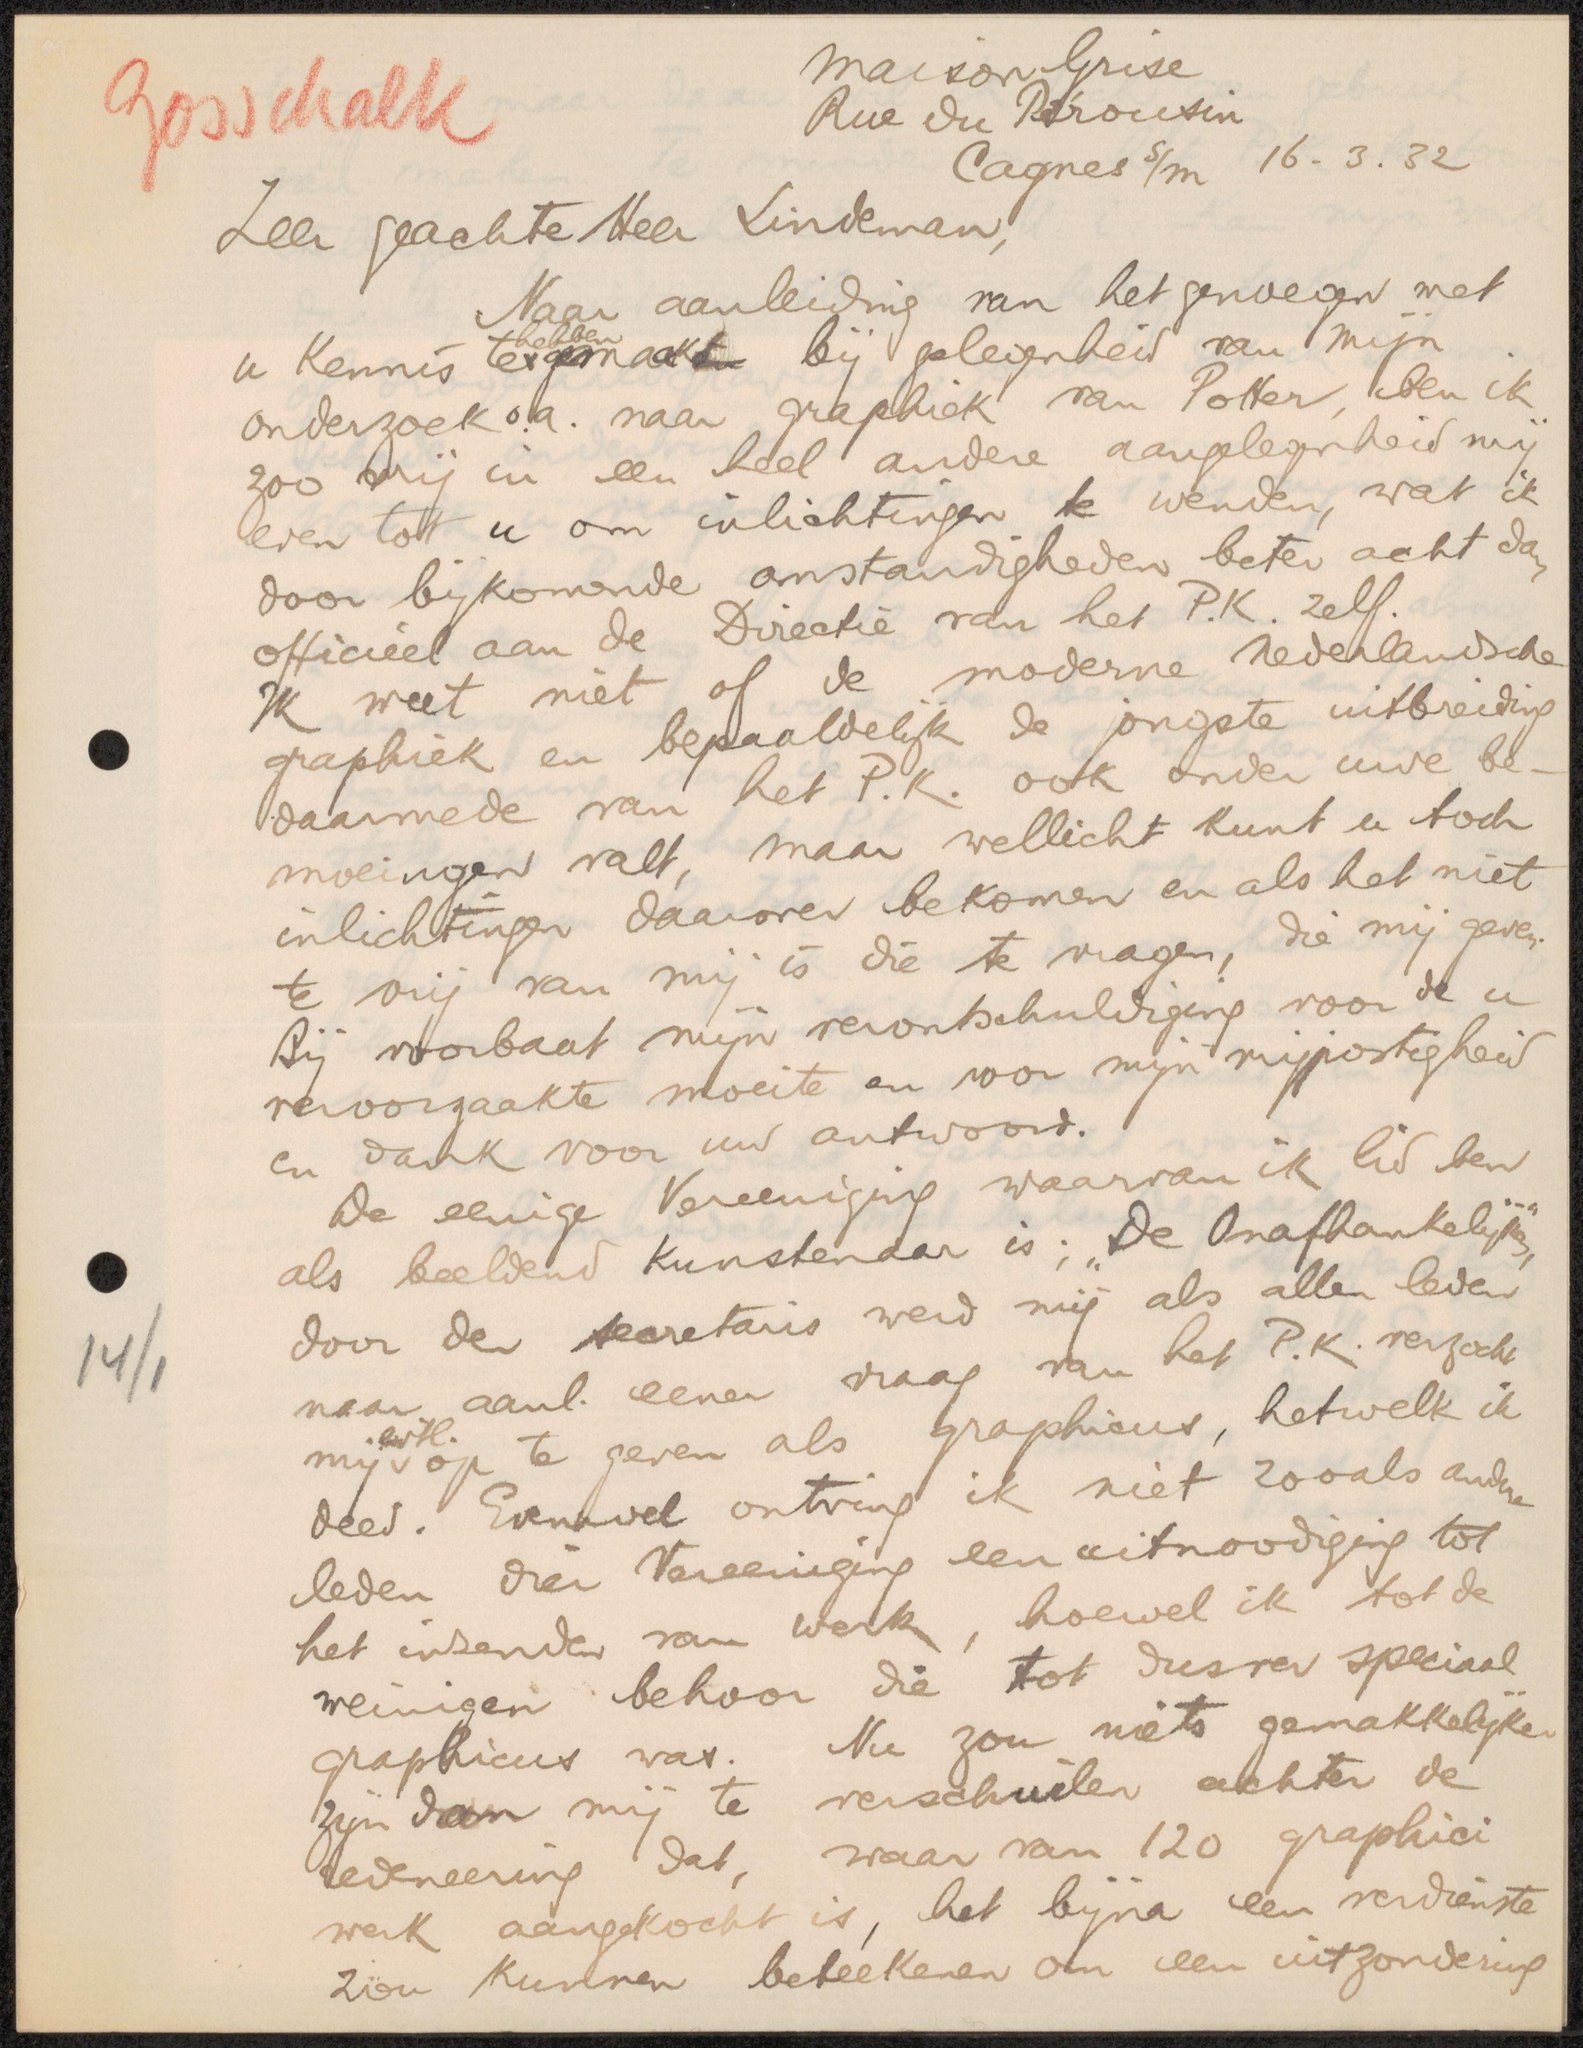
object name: letter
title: Brief aan C.M.A.A. Lindeman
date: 1932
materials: ink, paper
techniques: pen, writing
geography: cagnes-sur-mer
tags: print room, c.m.a.a. lindeman, drawing, the graphic arts, exhibition ~ art, art collecting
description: Brief bevat een concept voor een brief van jonkheer Hendrik Teding van Berkhout (1879-1969) aan Joseph Henry Gosschalk.